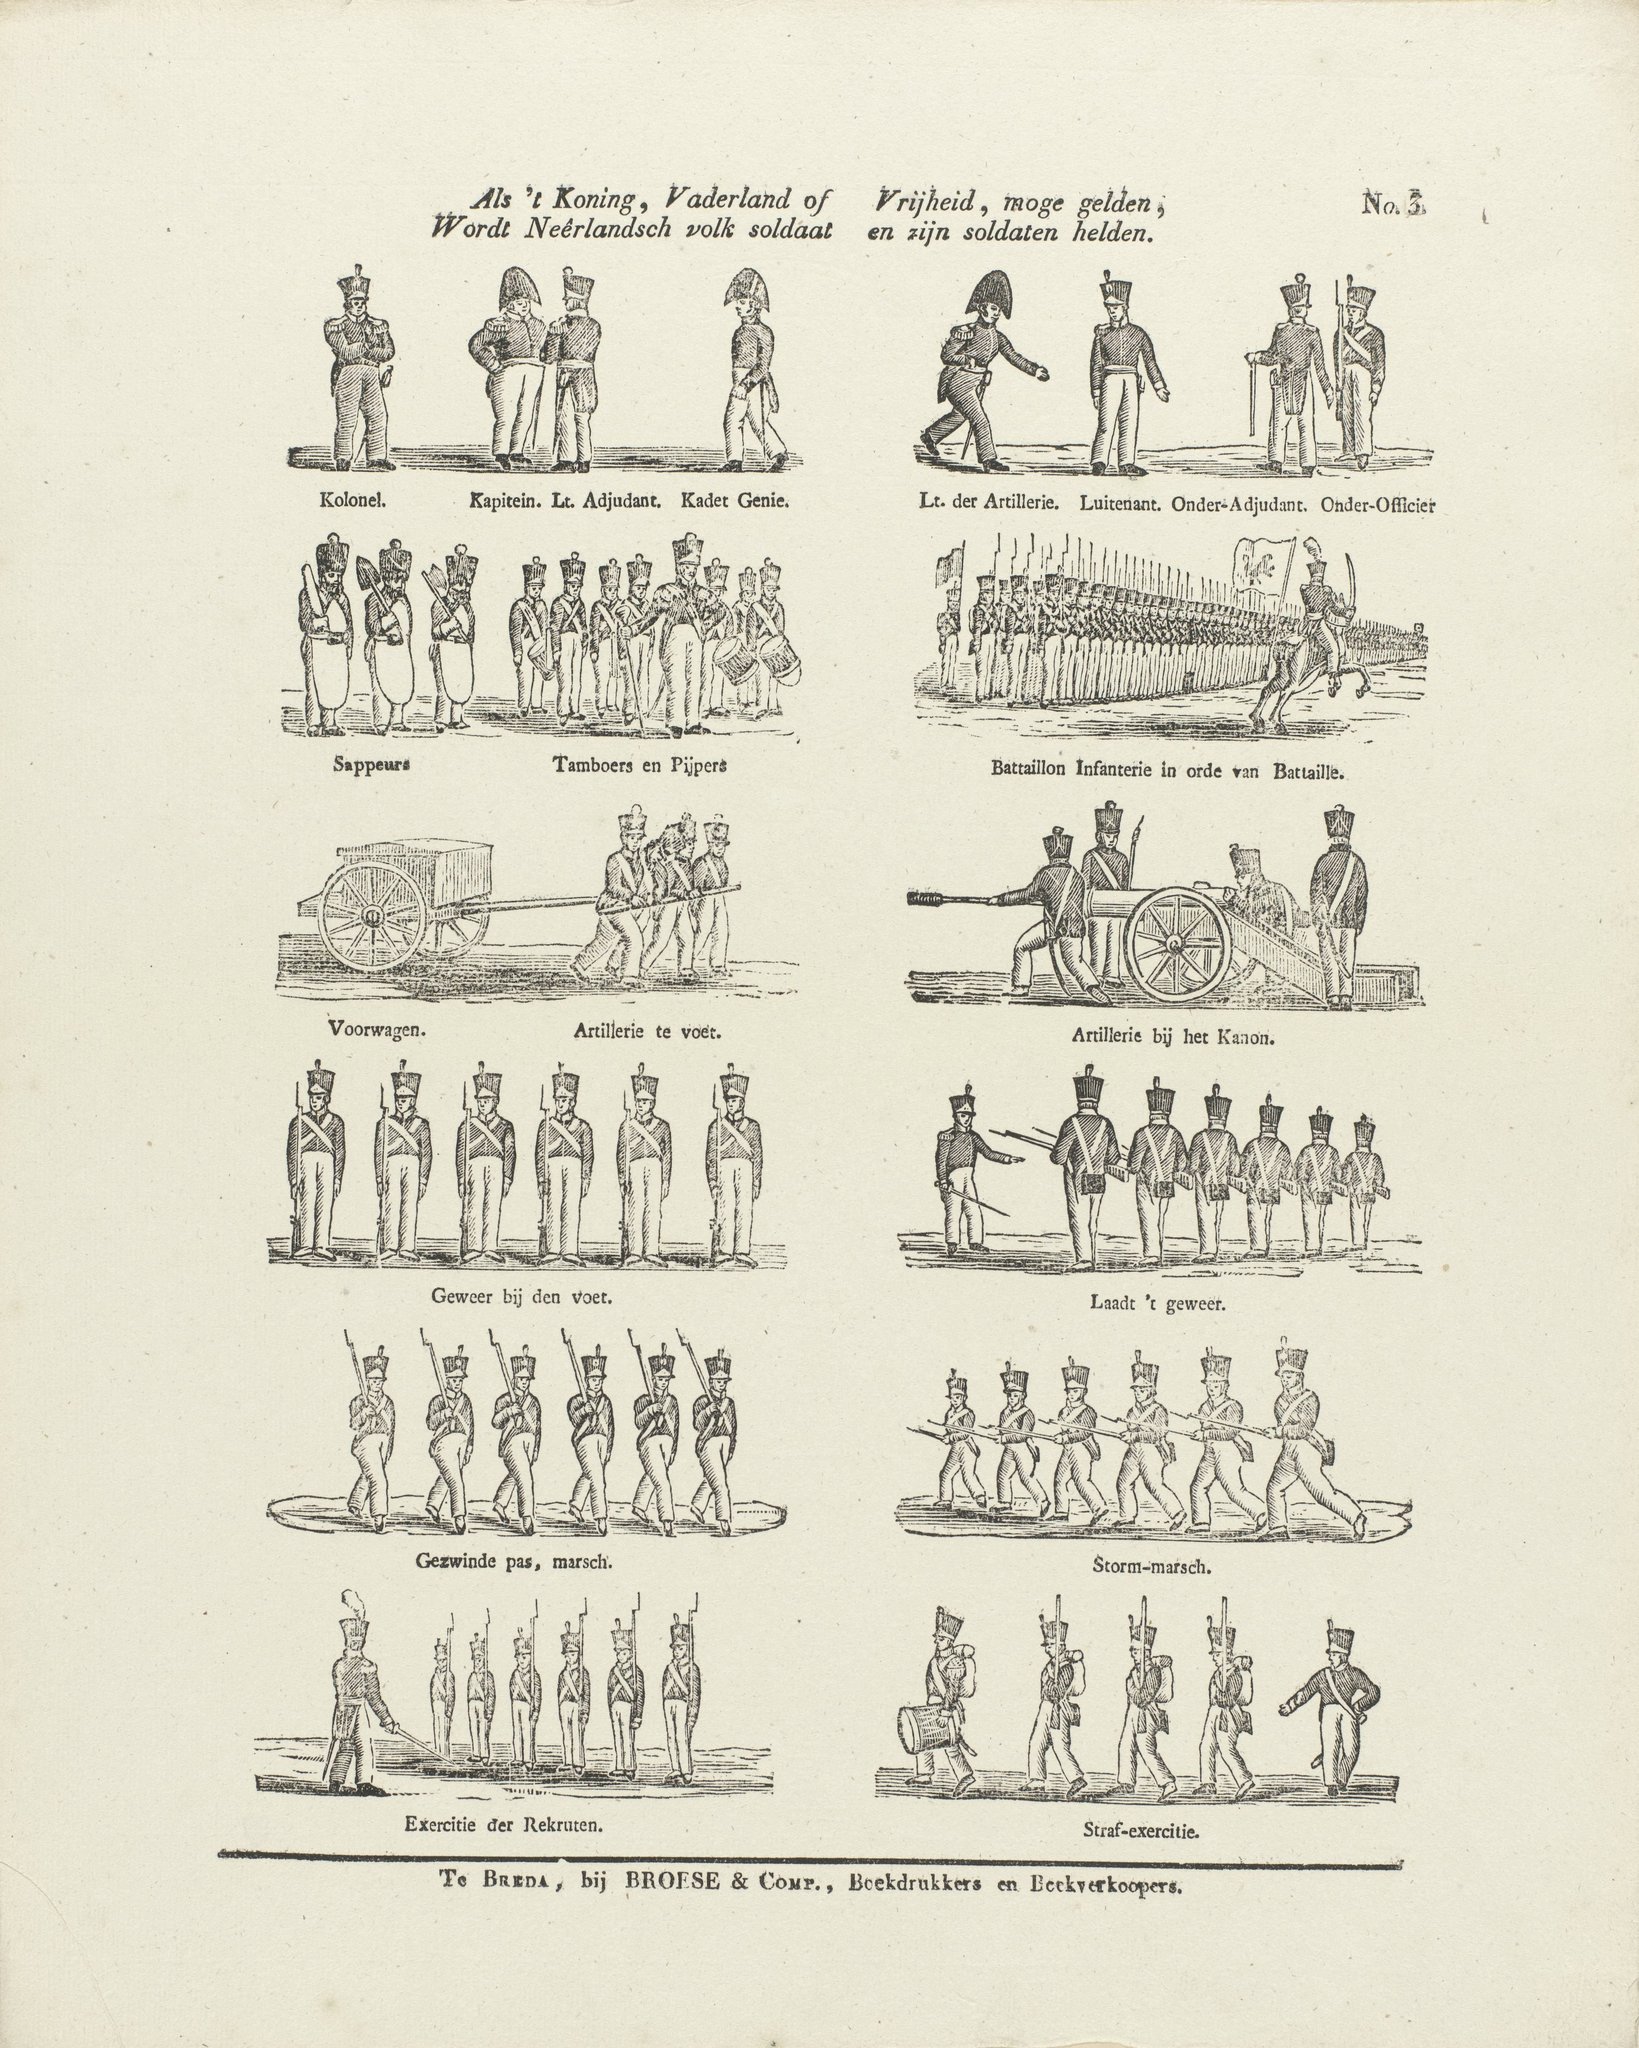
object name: popular print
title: Als 't koning, vaderland of vrijheid, moge gelden, / Wordt Neêrlandsch volk soldaat en zijn soldaten helden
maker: Anonymous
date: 1828-1853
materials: paper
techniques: letterpress printing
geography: breda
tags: weapons, the soldier; the soldier's life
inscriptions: collector's mark: Lugt 2760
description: Blad met 12 voorstellingen van verschillende rangen en exercities van Nederlandse soldaten. Onder elke voorstelling een onderschrift. Genummerd rechtsboven: No. 3.